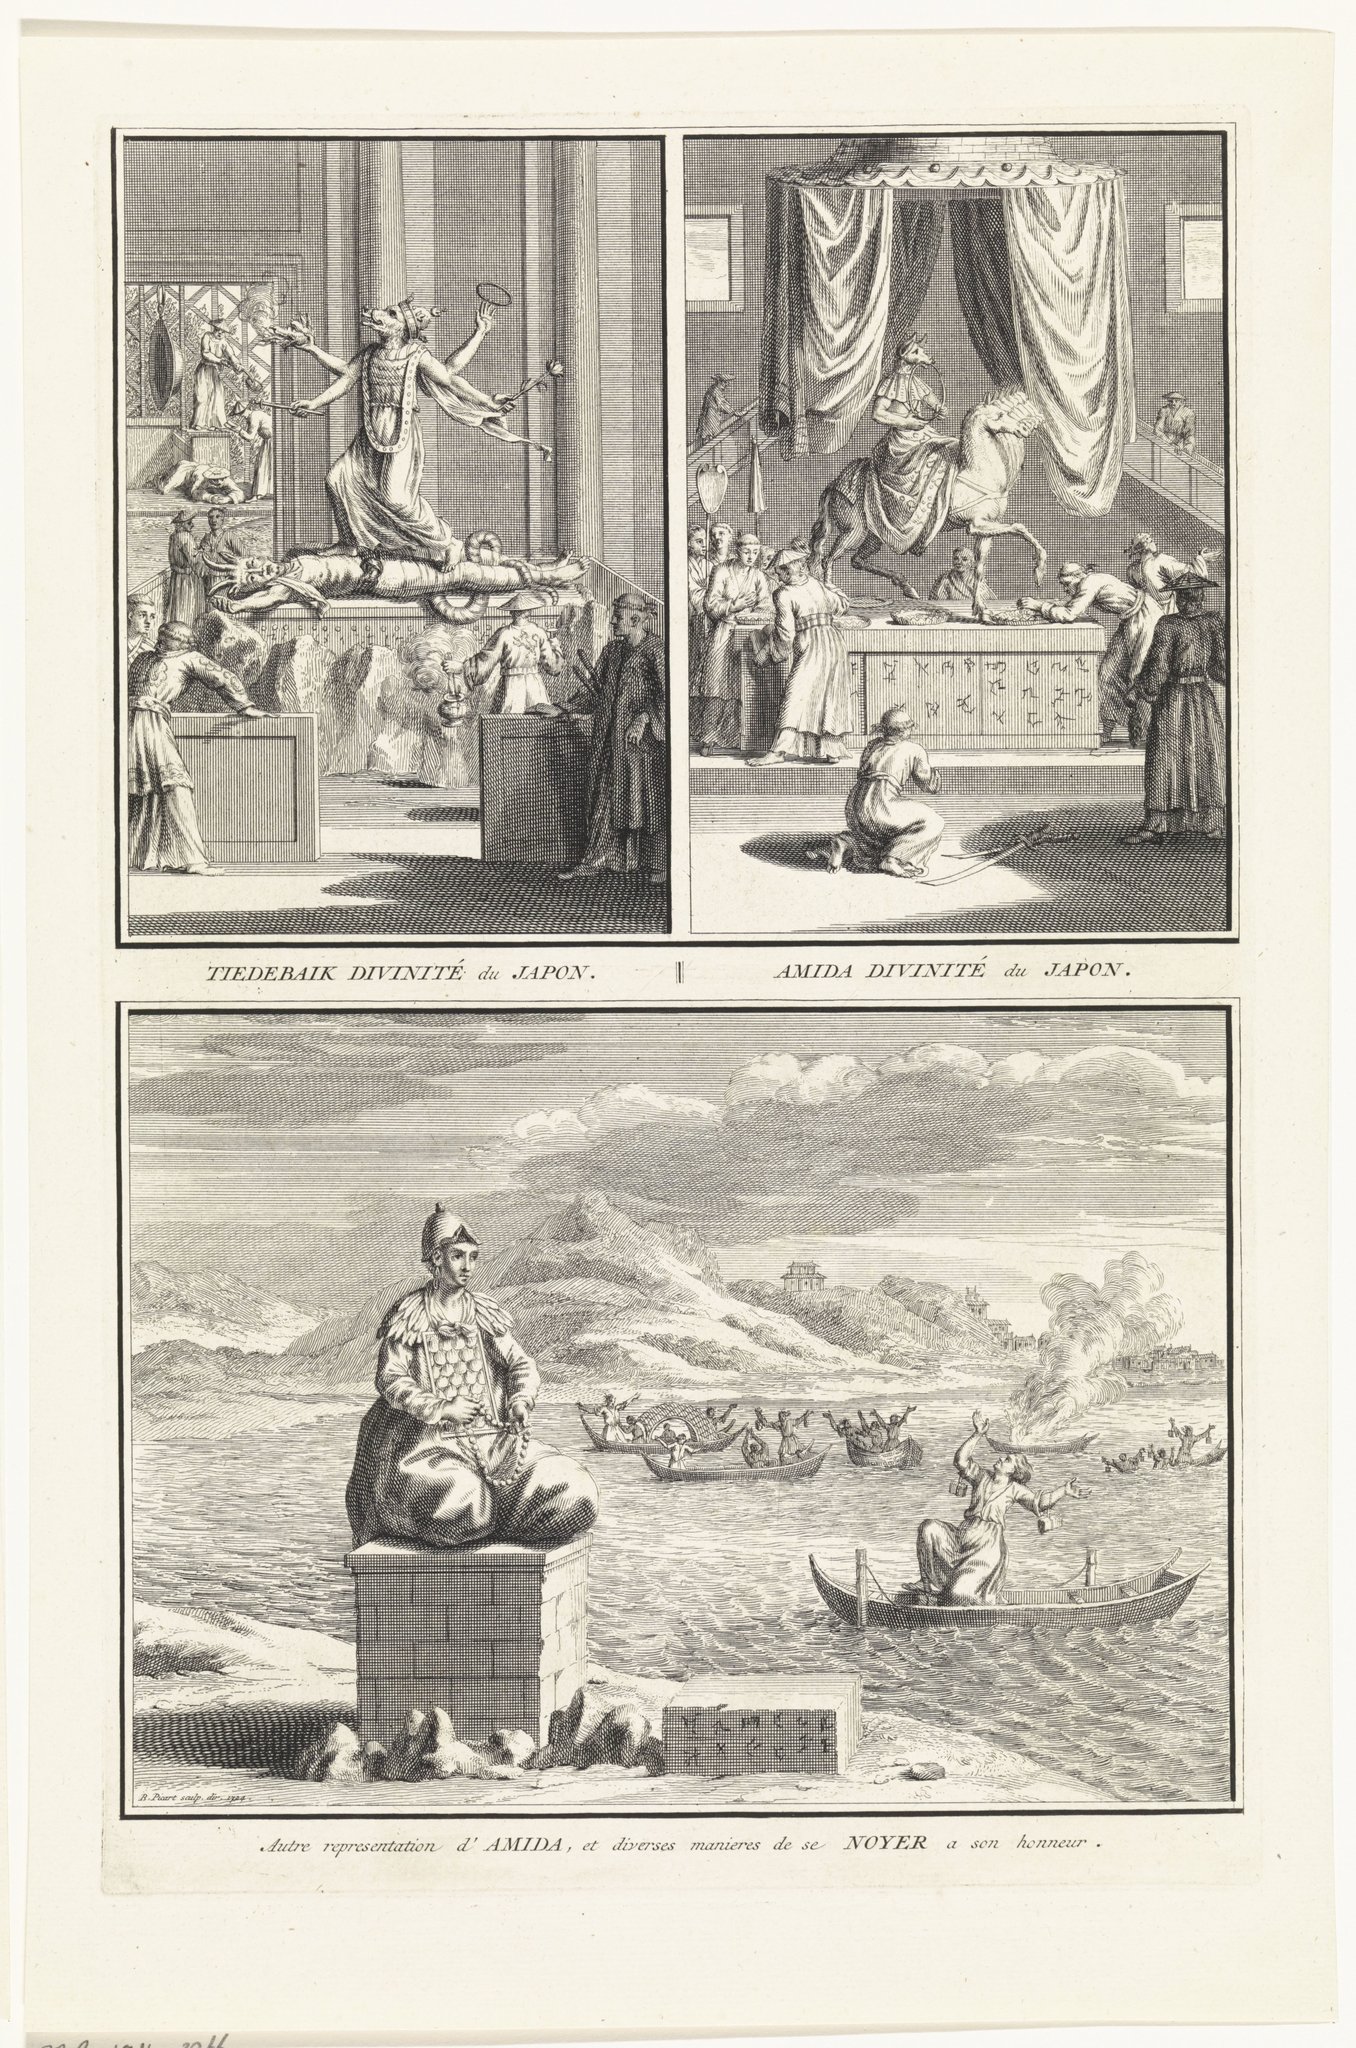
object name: book illustration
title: Vier Chinese goden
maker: bernard picart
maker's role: draughtsman, print maker, publisher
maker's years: 1673-1733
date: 1724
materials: paper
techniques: engraving, etching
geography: amsterdam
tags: shinto, japanese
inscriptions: collector's mark: Lugt 2228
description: Blad met drie voorstellingen van Japanse goden. Linksboven: Standbeeld van de Japanse god Tiedebaik. Rechtsboven: Standbeeld van de god Amida. Onder: Op de voorgrond de Japans boedistische god Amida. Op de achtergrond mensen met gewichten aan hun armen en voeten in bootjes, zodat ze ter ere van hun god zullen verdrinken.